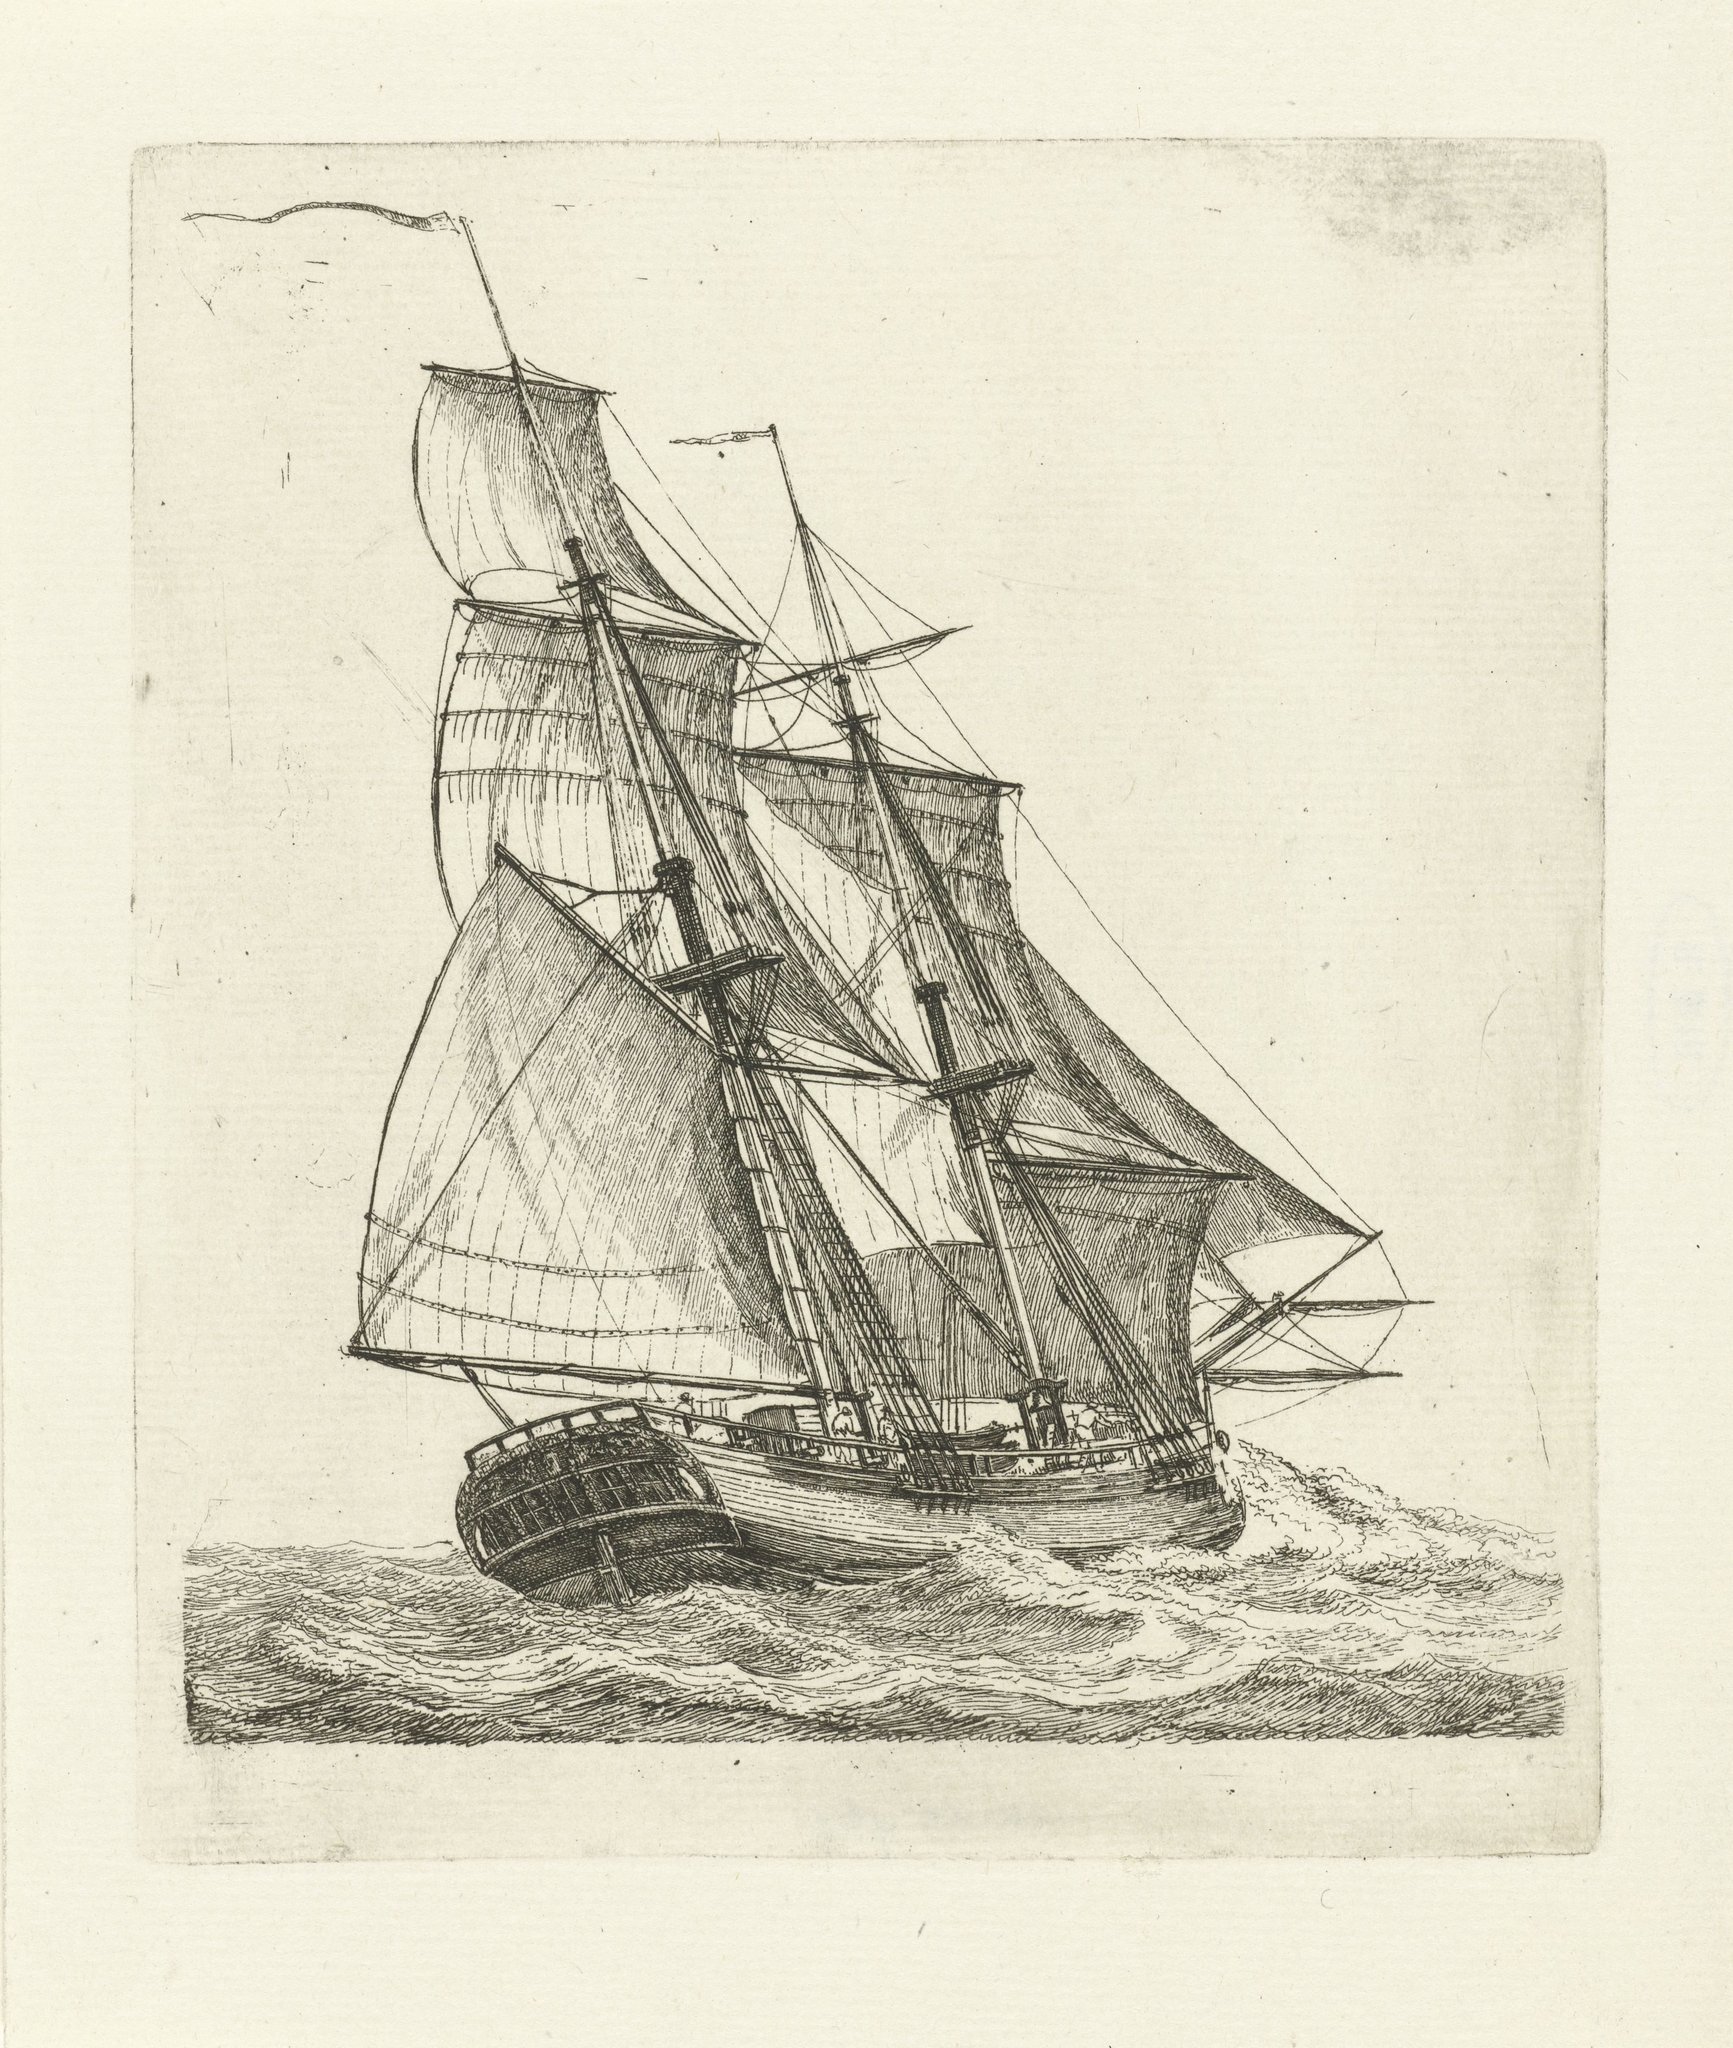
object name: print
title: Verschillende schepen serie E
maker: gerrit groenewegen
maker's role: draughtsman, print maker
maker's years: 1754-1826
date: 1790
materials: paper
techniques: etching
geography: rotterdam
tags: ships (in general)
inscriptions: collector's mark: Lugt 2228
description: Een tweemaster met spiegel op de golven, schuin van achter gezien. Op het dek ligt een boot en zijn een klok en een aantal figuren te zien. Deze prent maakt deel uit van een serie van twaalf prenten met verschillende zeilschepen.